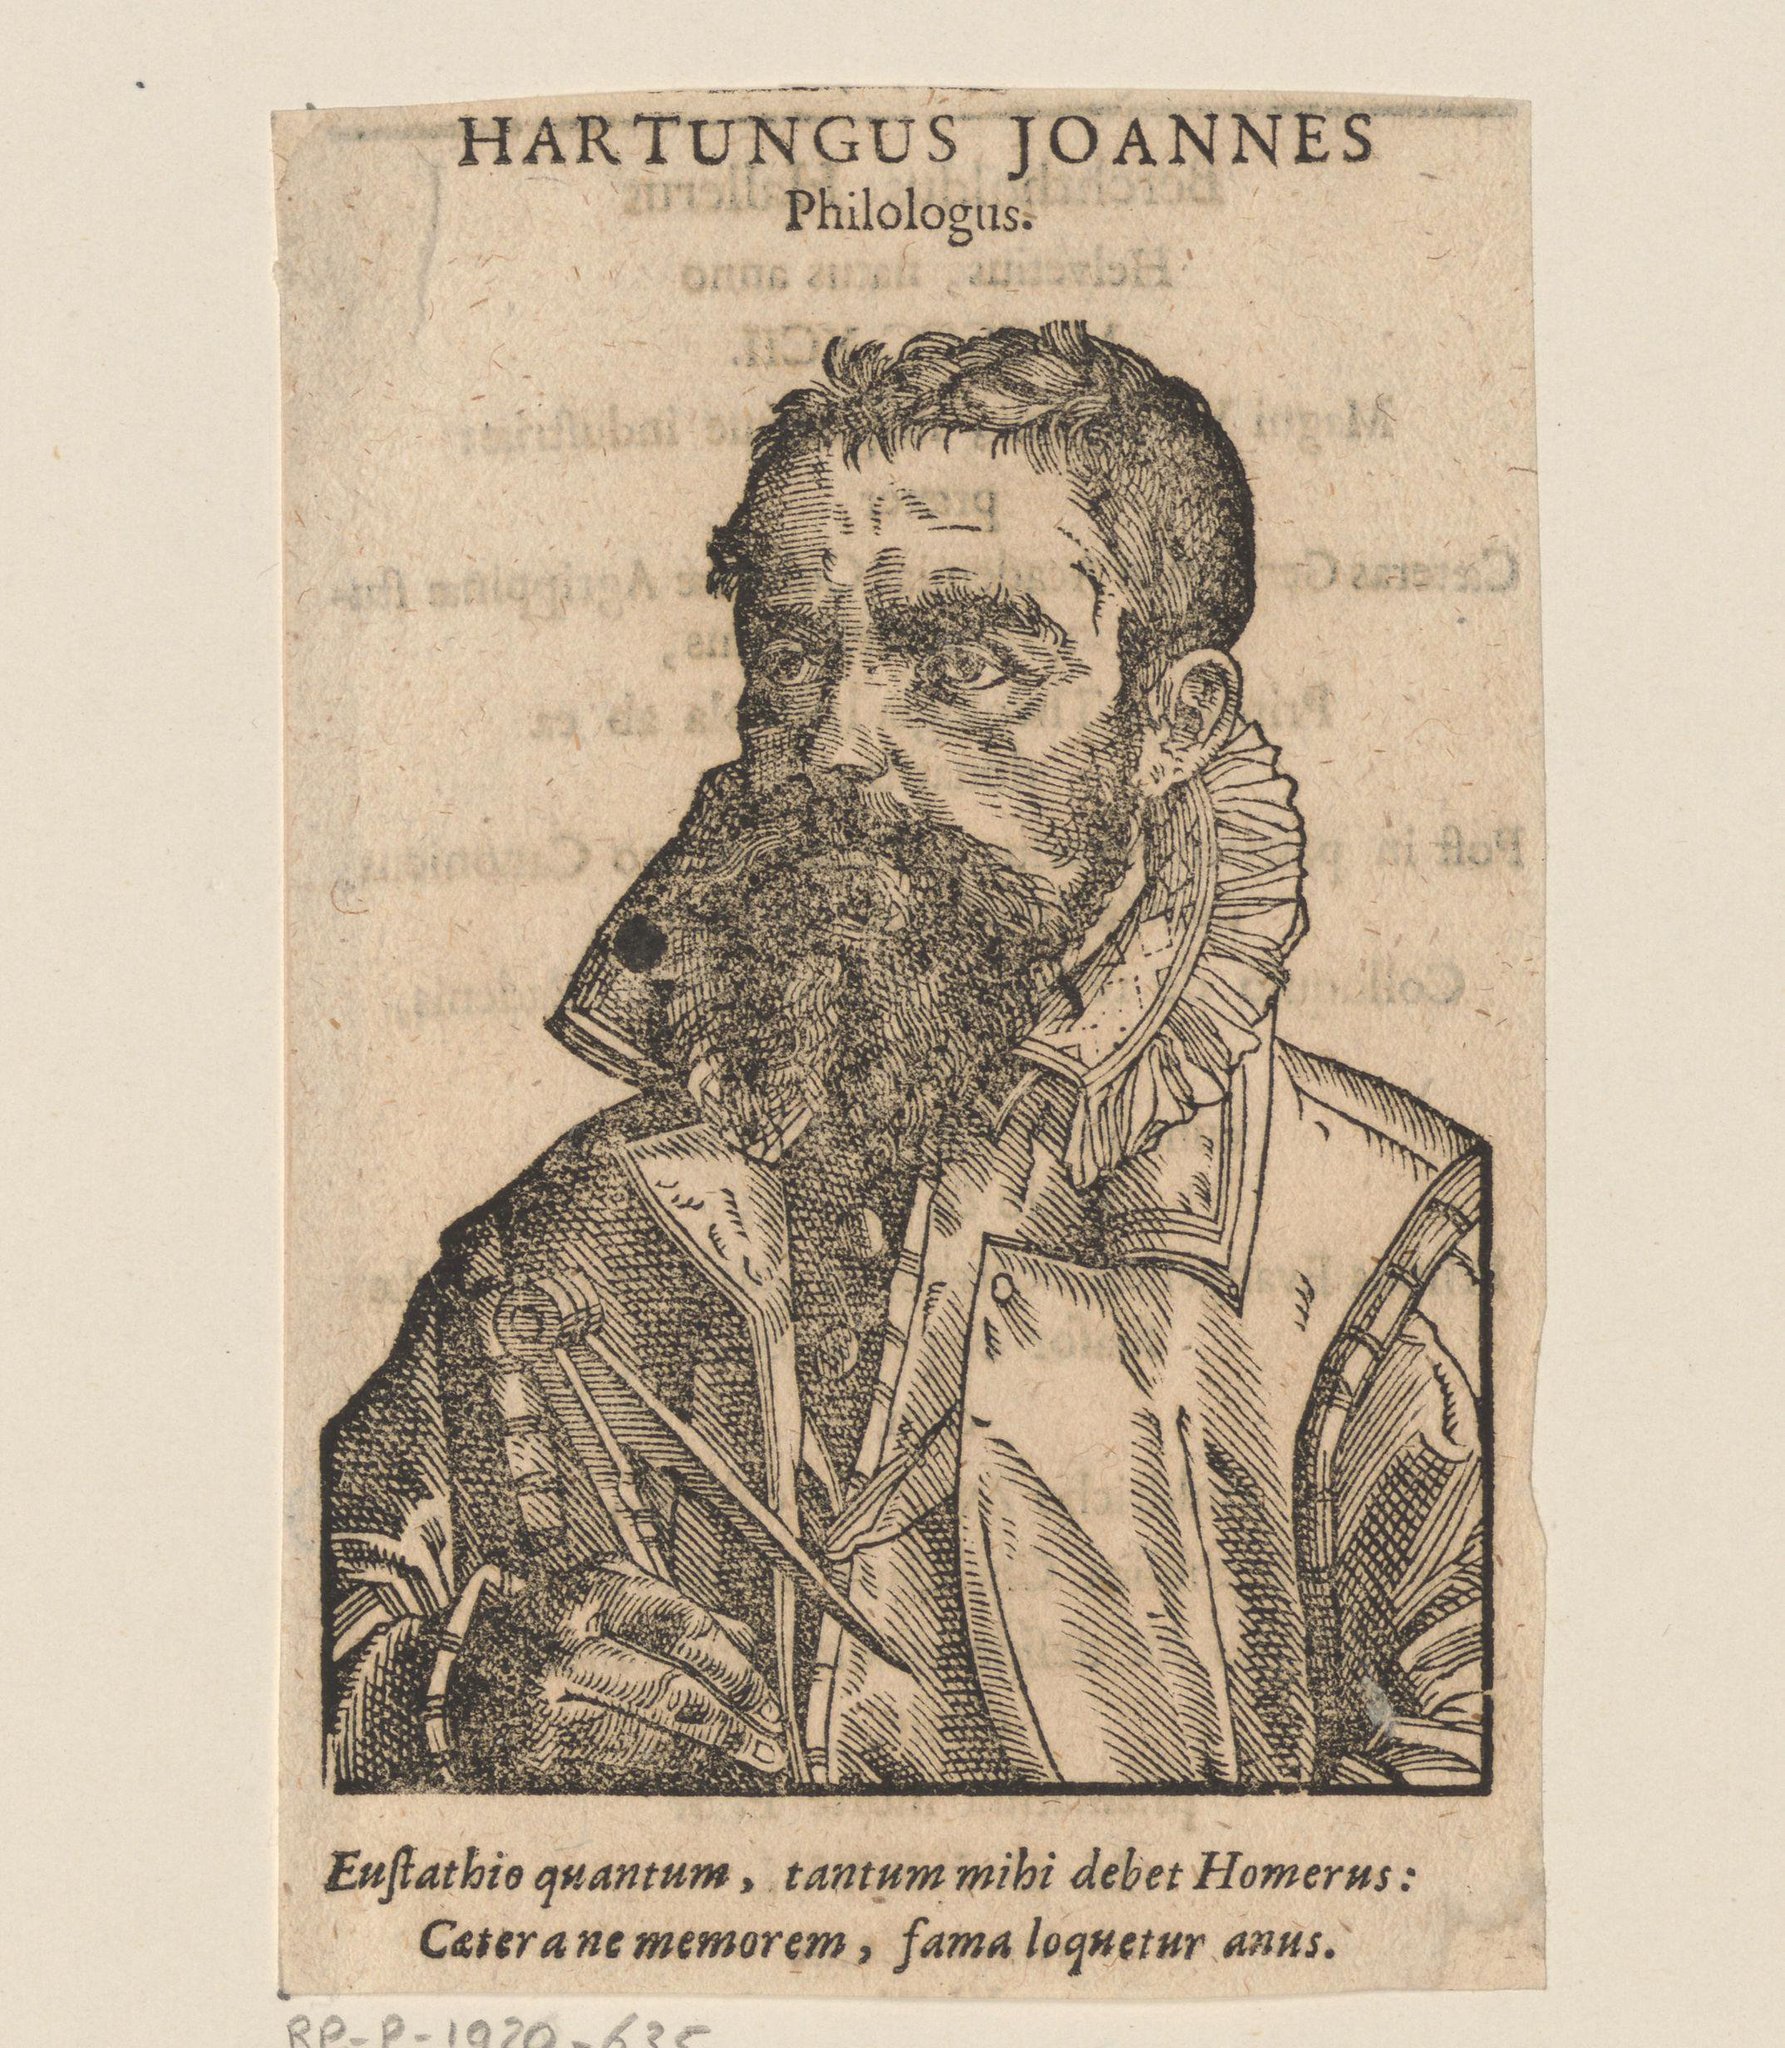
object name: book illustration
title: Portret van Johannes Hartung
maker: johann balthasar diehl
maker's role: printer, publisher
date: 1719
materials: paper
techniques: letterpress printing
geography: frankfurt am main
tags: scholar, philosopher, historical persons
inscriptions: collector's mark: Lugt 2228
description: Prent uit: Reusner, Nikolaus. Icones sive imagines virorum literis illustrium qui seculo XV. (...). Frankfurt am Main: Johann Balthasar Diehl, 1719, p. 74. Prent voor het eerst verschenen in de eerste editie van 1587.